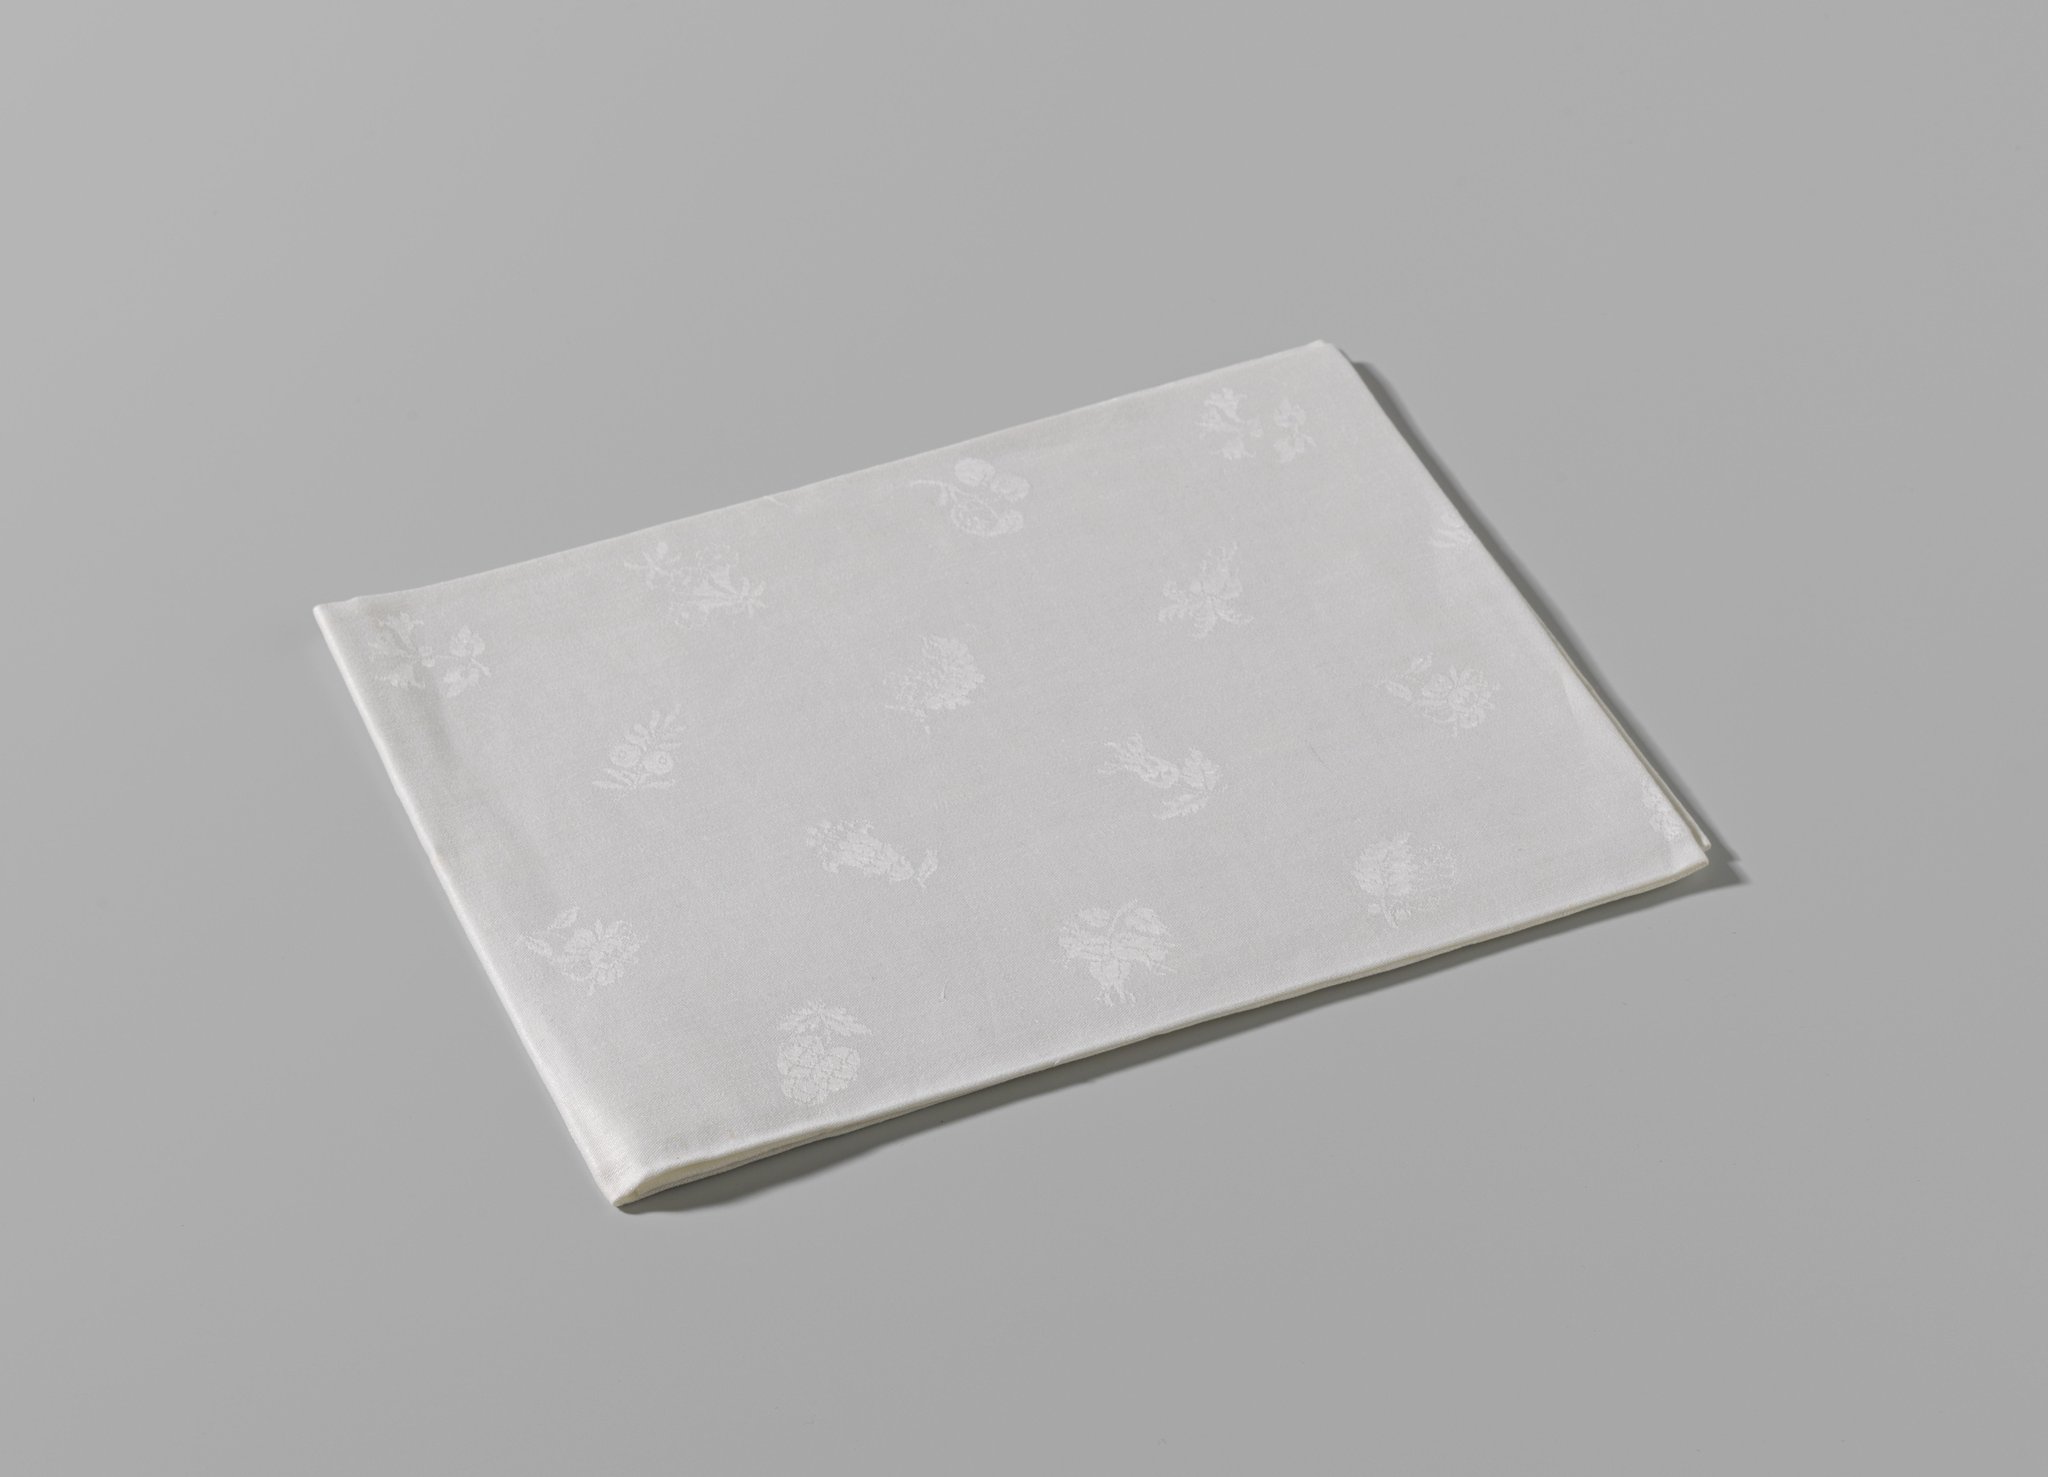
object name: napkin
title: Servet met patroon van diverse vruchten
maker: Anonymous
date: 1800-1900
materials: linen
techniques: damask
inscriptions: label: ‘R.M. A'dam’, monogram: ‘TvBF’, number: ‘36’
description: Servet van linnendamast met patroon van diverse vruchten en bloemen op het middenveld.